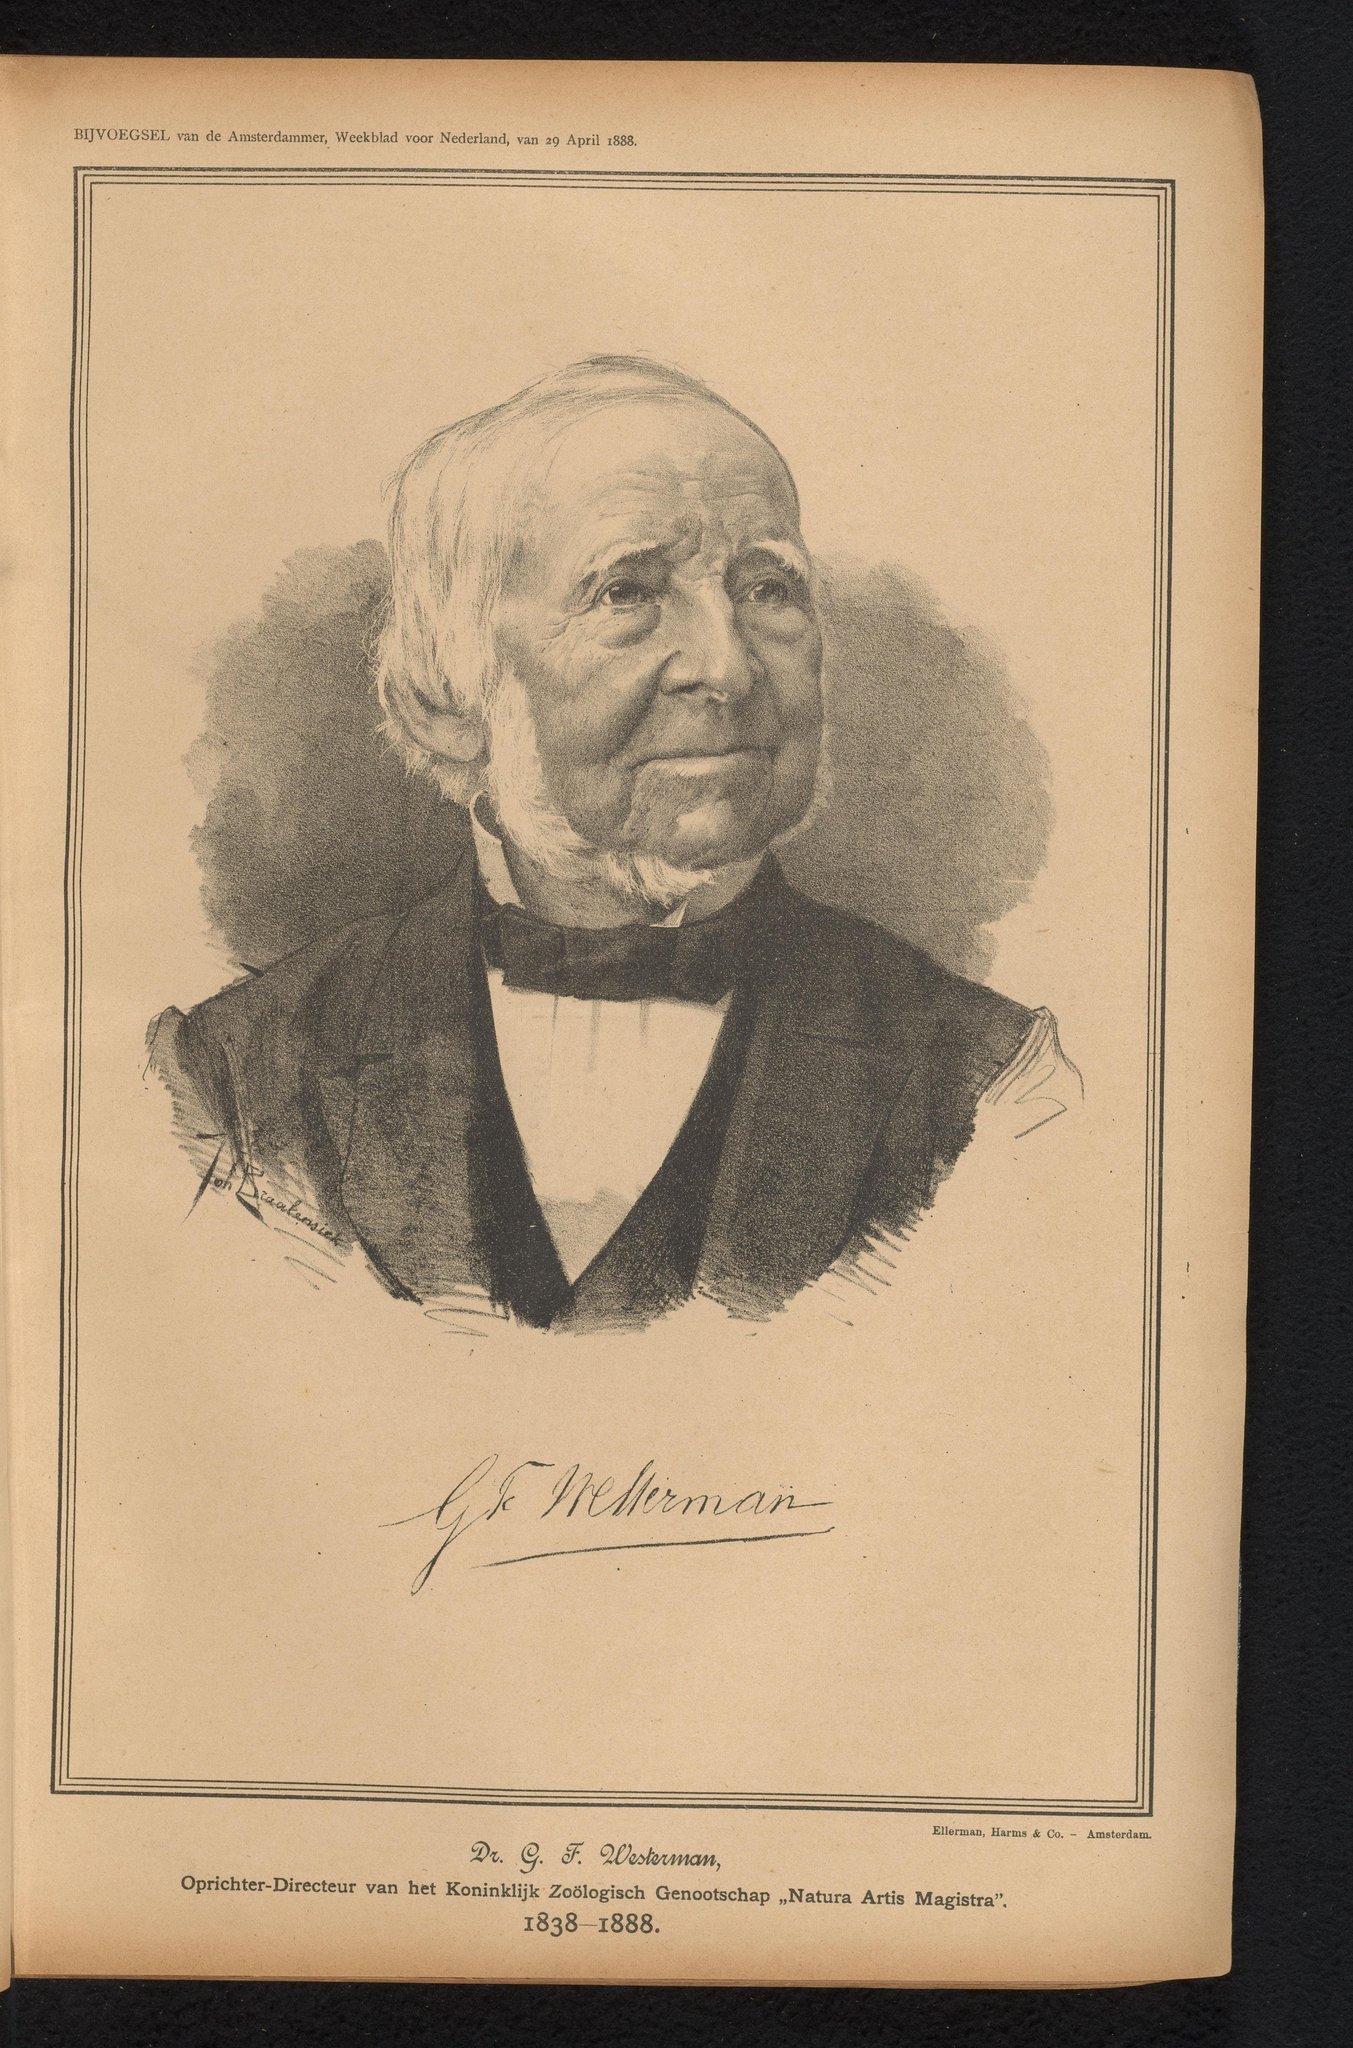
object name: print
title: Dr. G.F. Westerman, Oprichter-Directeur van het Koninklijk Zoölogisch Genootschap "Natura Artis Magistra". 1838-1888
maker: johan braakensiek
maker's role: draughtsman, print maker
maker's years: 1858-1940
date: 1888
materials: paper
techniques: lithograph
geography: amsterdam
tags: rotterdam, gerardus frederik westerman, historical persons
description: Portret van Gerardus Frederik Westerman, oprichter van het Koninklijk Zoölogisch Genootschap 'Natura Artis Magistra', bij zijn 50ste verjaardag.